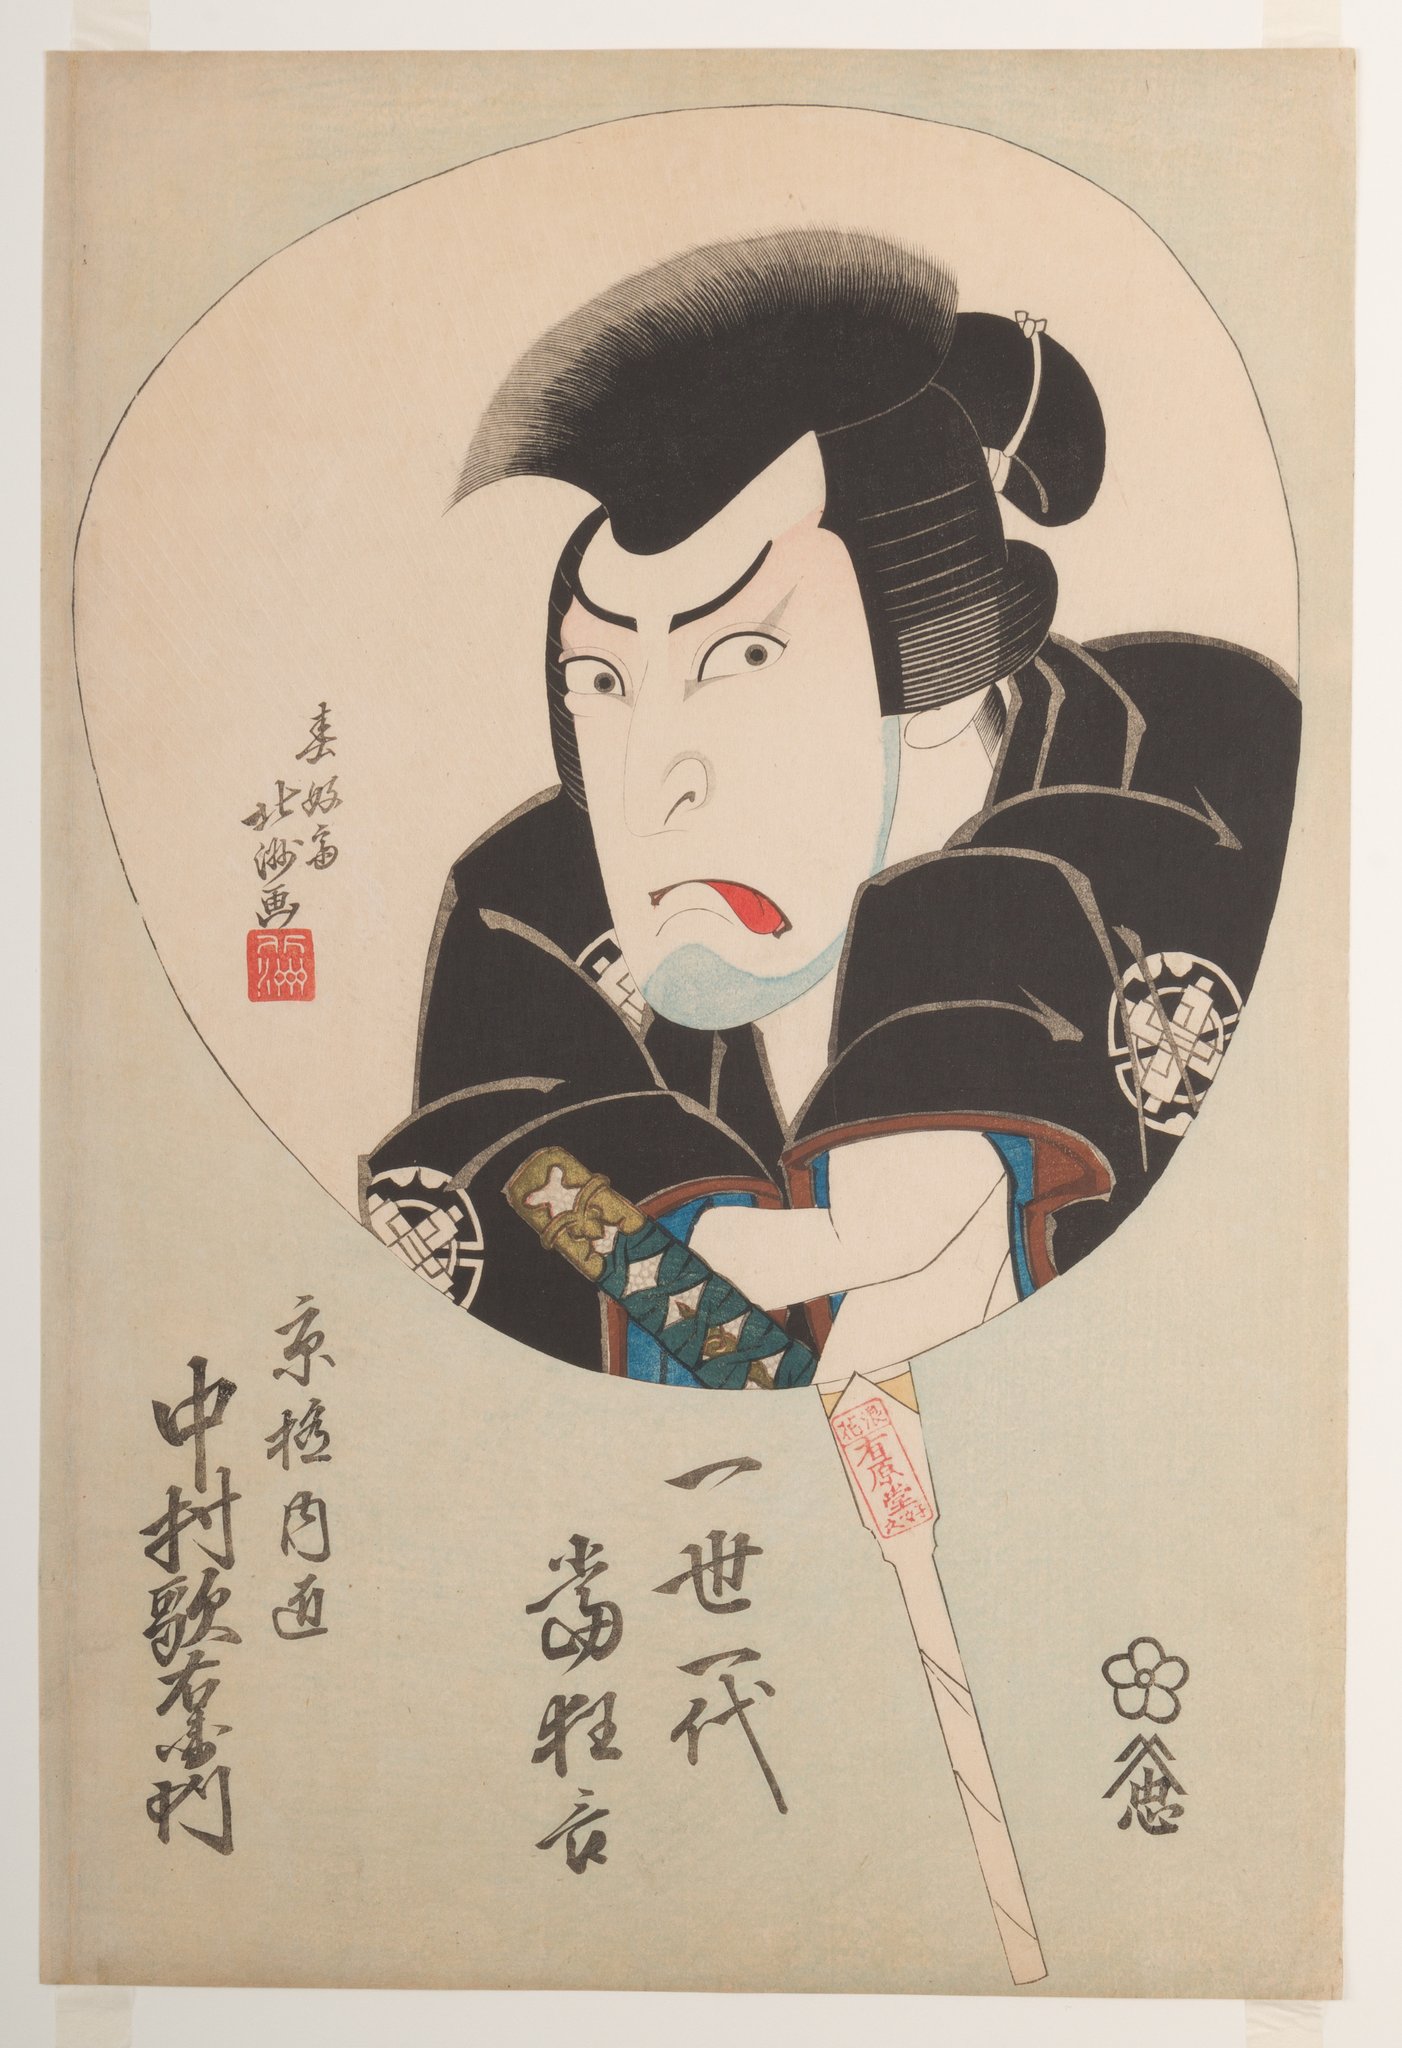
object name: woodblock print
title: Kabuki Actor Nakamura Utaemon III as the Sword Master Kyōgoku Takumi, from the series Issei ichidai atari Kyōgen (Hits of a Lifetime of Kyōgen)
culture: japanese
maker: shunkōsai hokushū 春好斎北洲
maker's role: artist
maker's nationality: japanese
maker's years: 1808-1832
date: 1825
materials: ink, paper, pigment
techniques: woodblock print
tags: men,actors